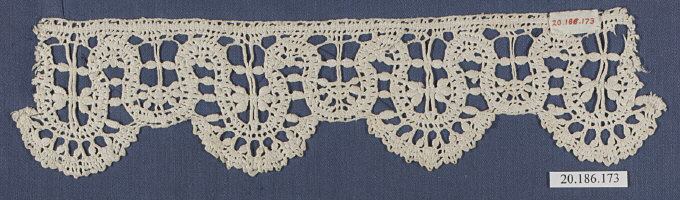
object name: edging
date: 1601-1700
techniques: lace